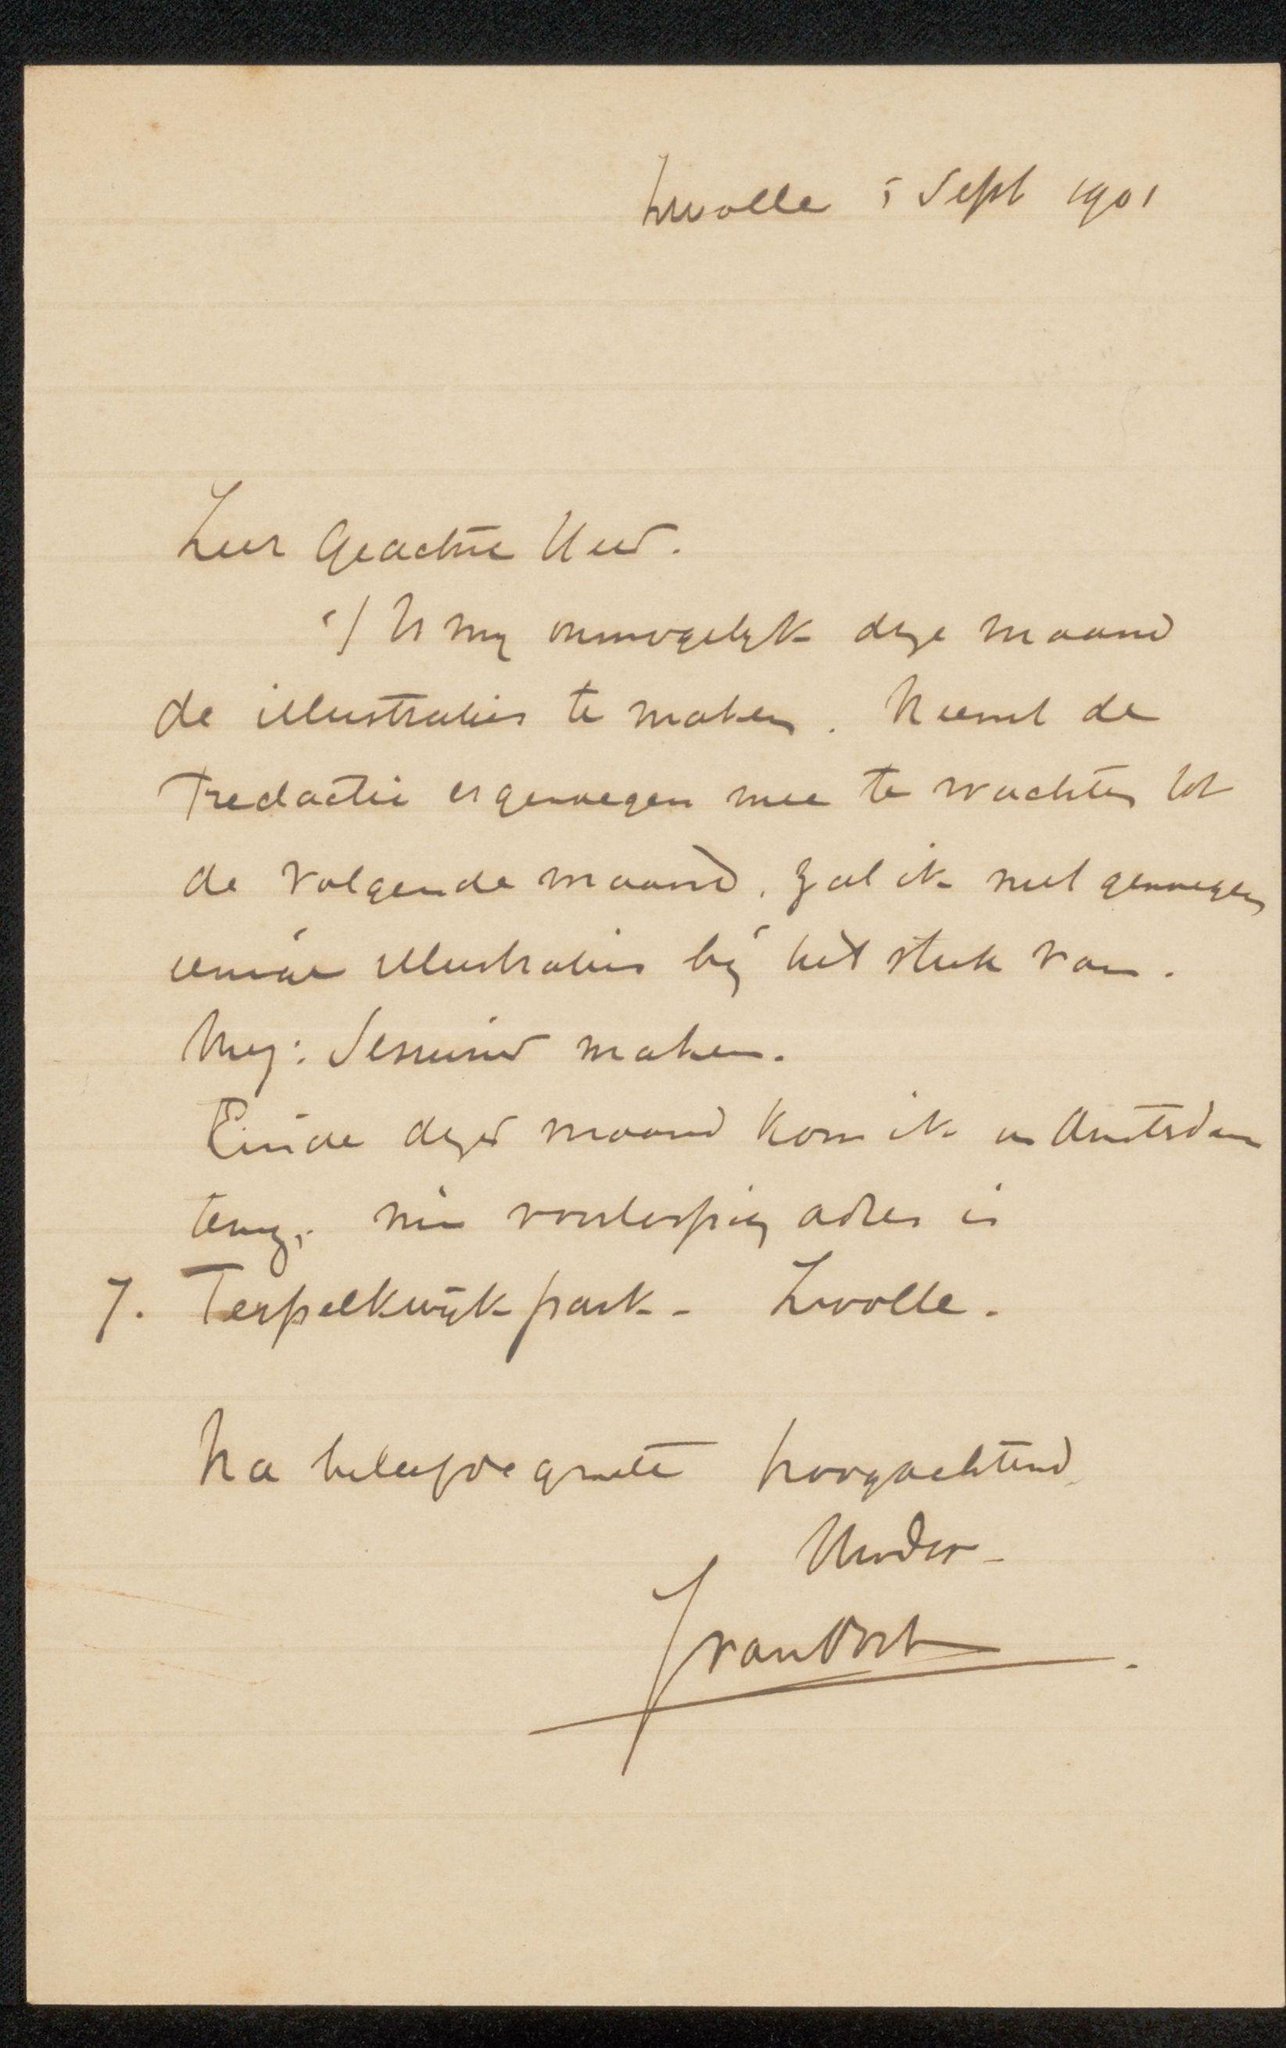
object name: letter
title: Brief aan Philip Zilcken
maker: jan van oort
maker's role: draughtsman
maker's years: 1867-1938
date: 1901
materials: ink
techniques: pen, writing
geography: zwolle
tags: liège, antwerp, the hague, draughtsman, philip zilcken, illustration ~ printed matter, book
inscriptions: collector's mark: ‘RPK’